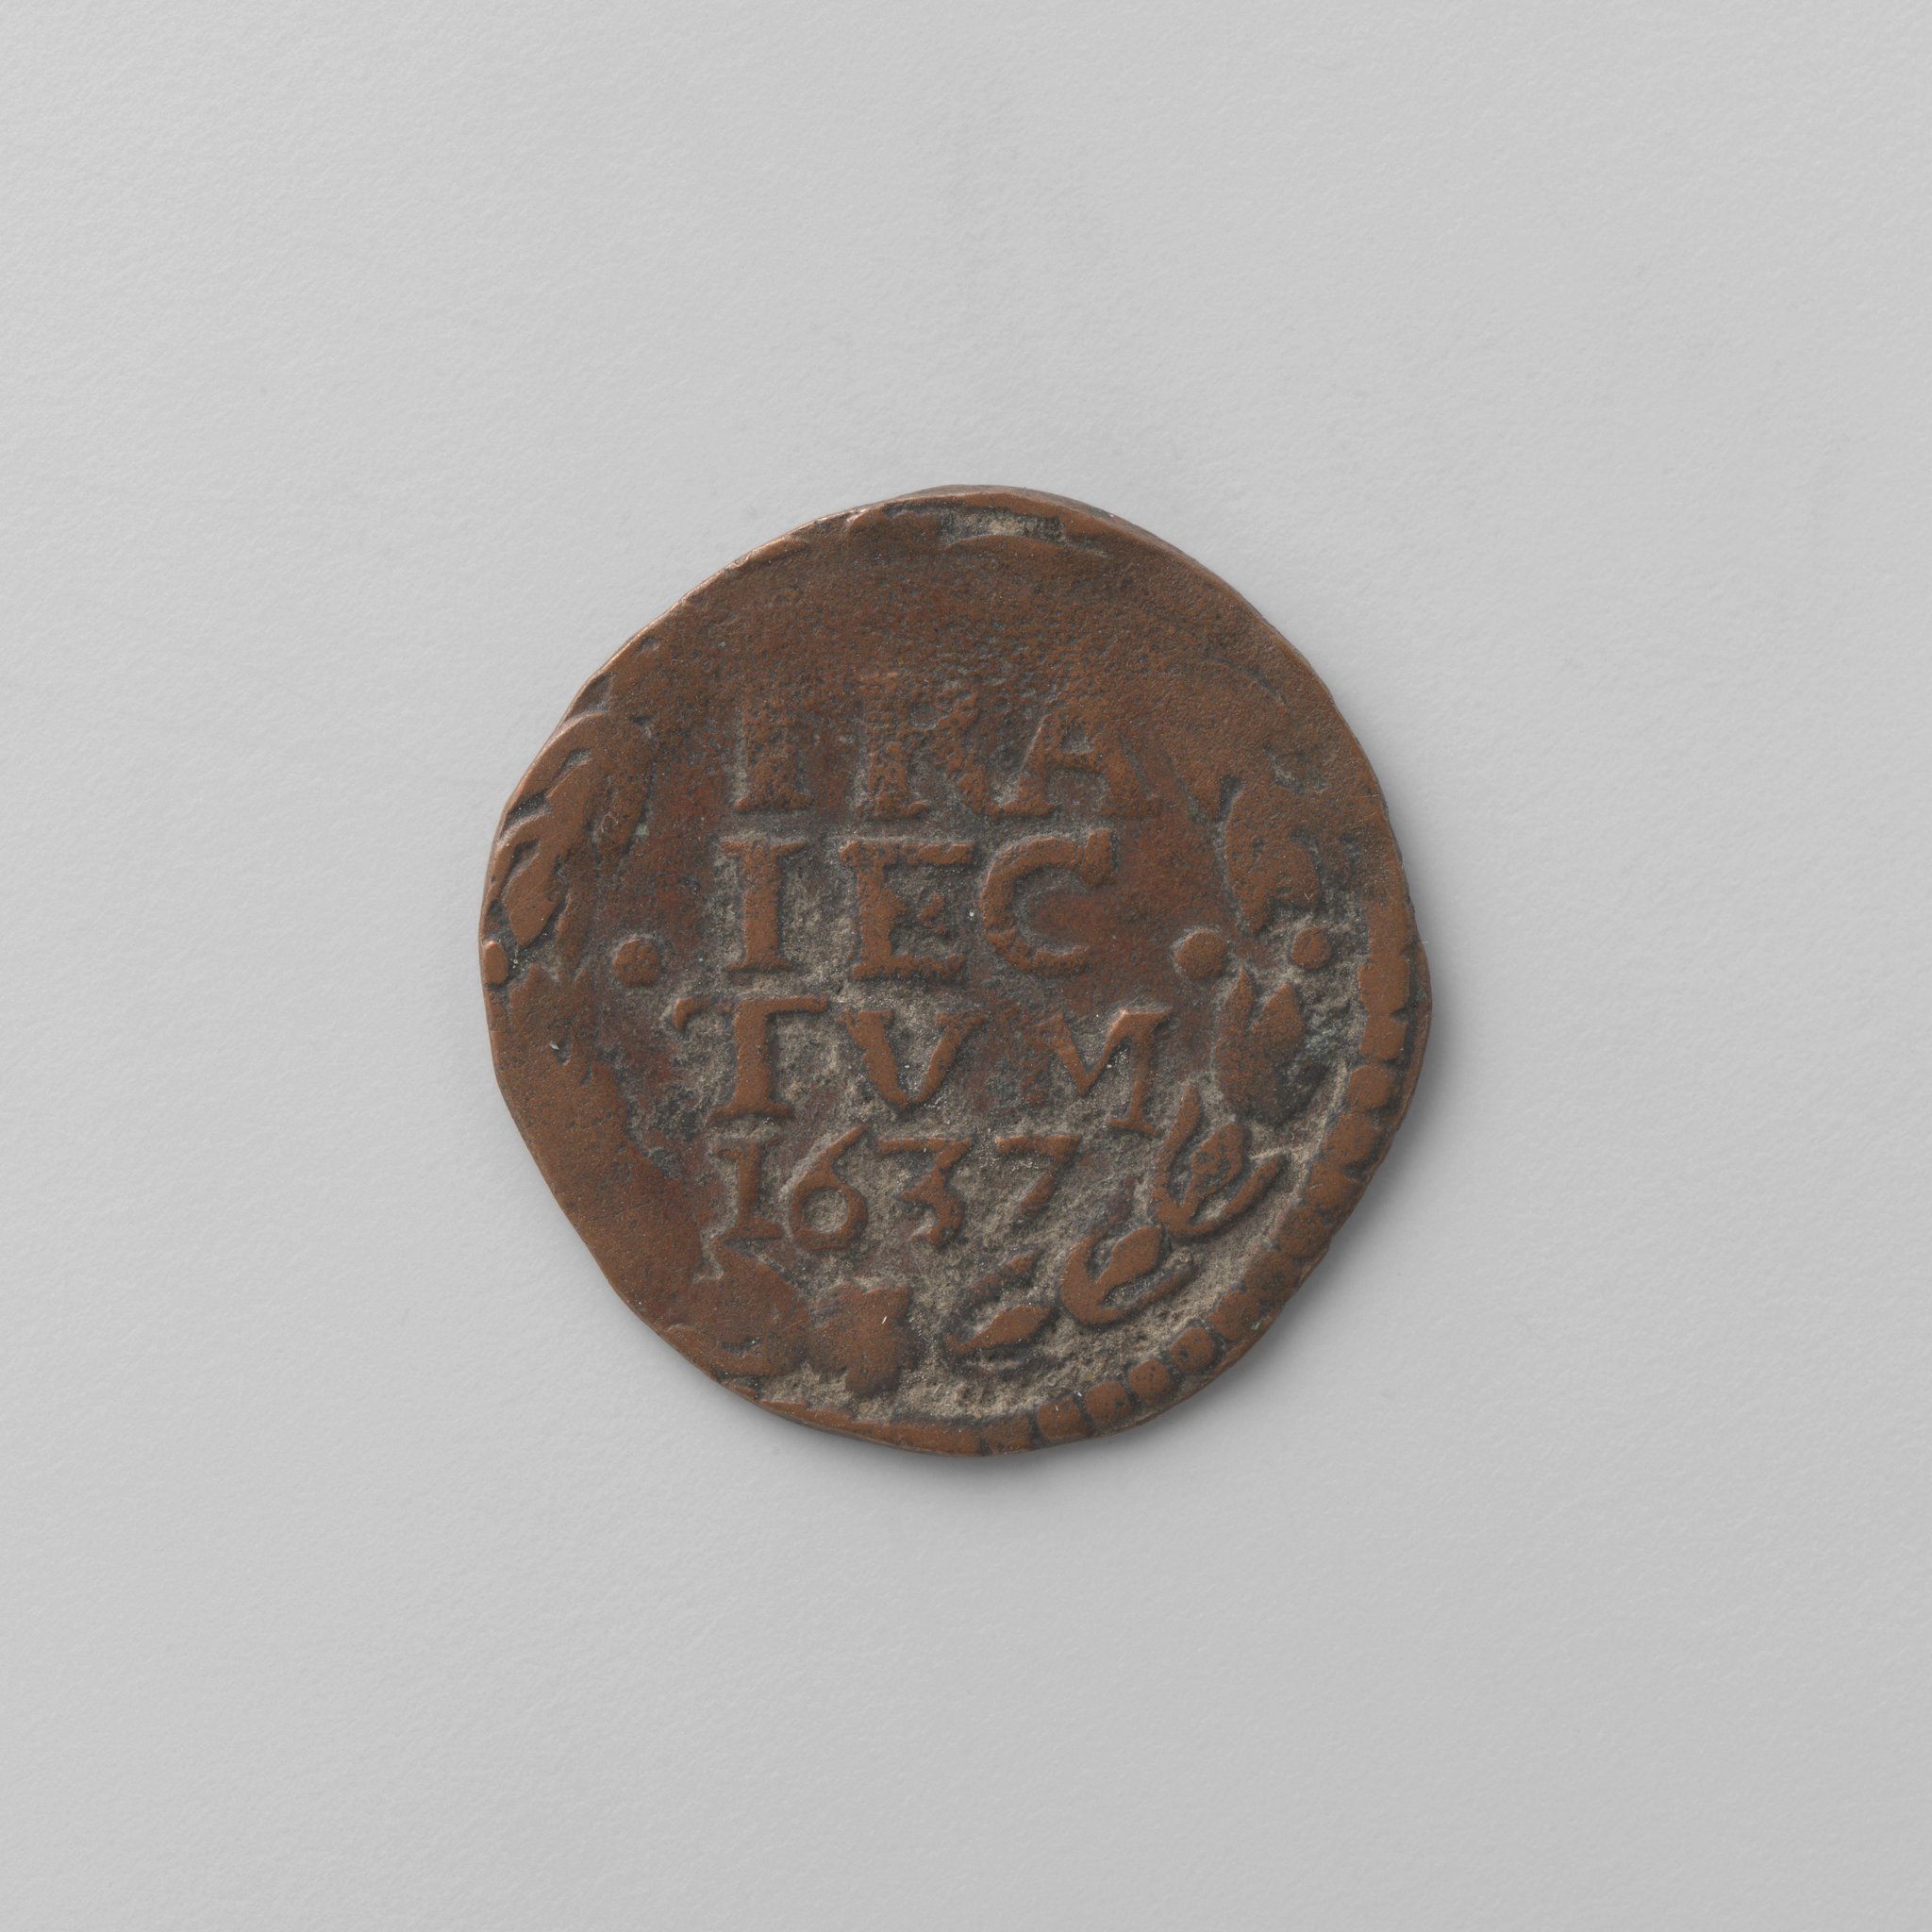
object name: coin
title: Duit van de stad Utrecht, 1637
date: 1637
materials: copper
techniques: striking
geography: utrecht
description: Koperen munt. Voorzijde: op lang gebloemd kruis gedamasceerd wapenschild van de stad Utrecht. Keerzijde: binnen een bladerkrans opschrift in drie regels, waaronder jaartal.